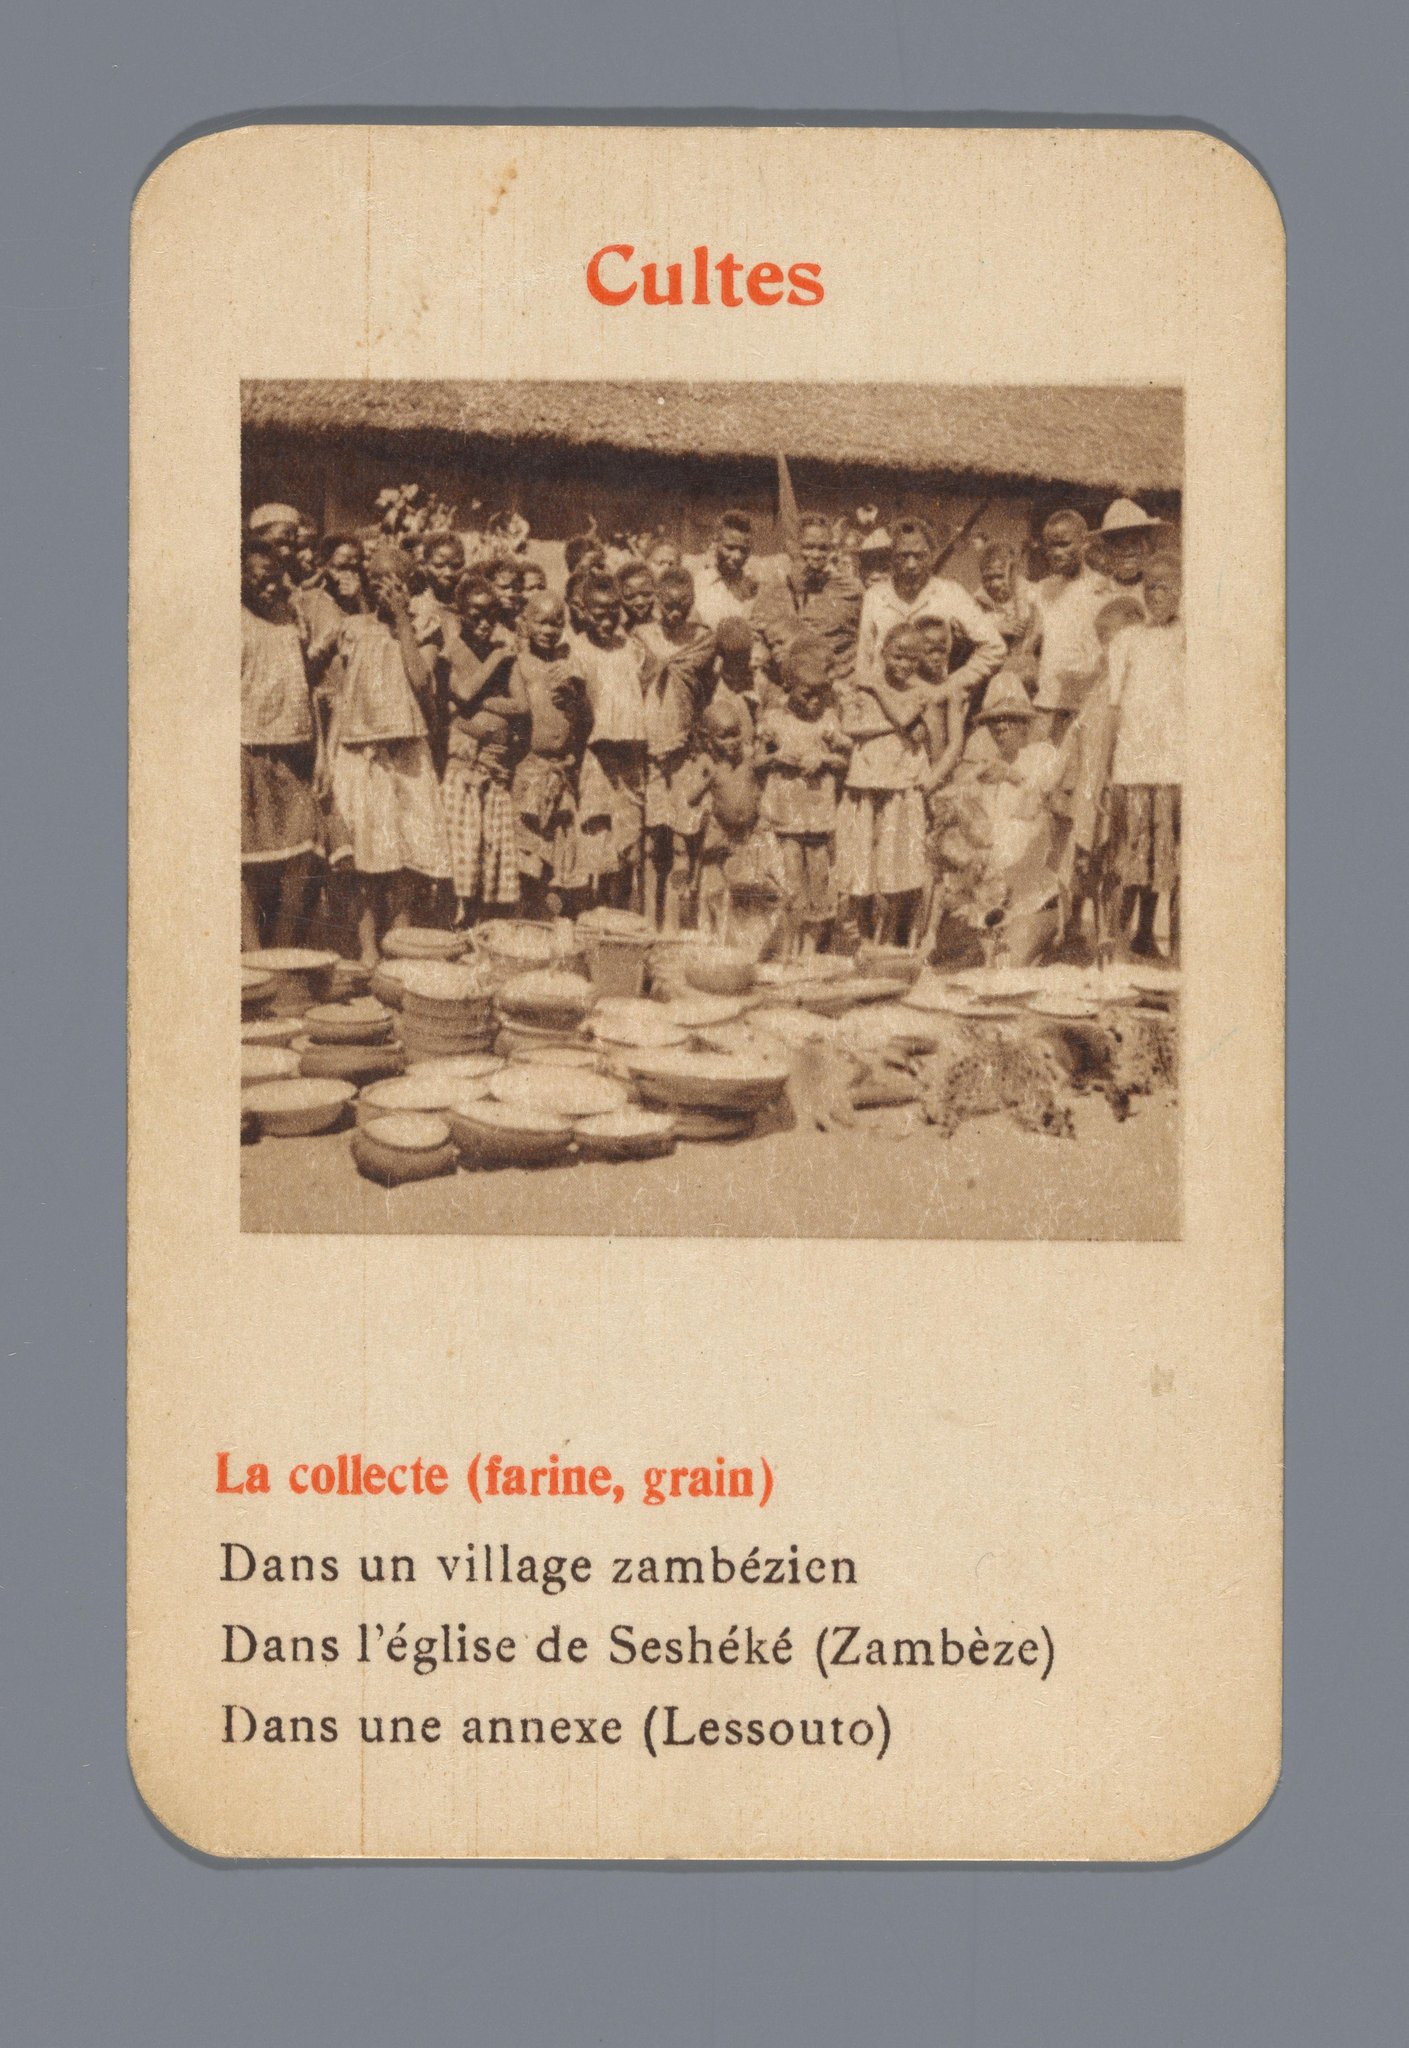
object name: card game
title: Meel- en graanmarkt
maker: Anonymous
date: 1900-1920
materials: cardboard, paper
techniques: rotogravure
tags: african traditional religions, card games